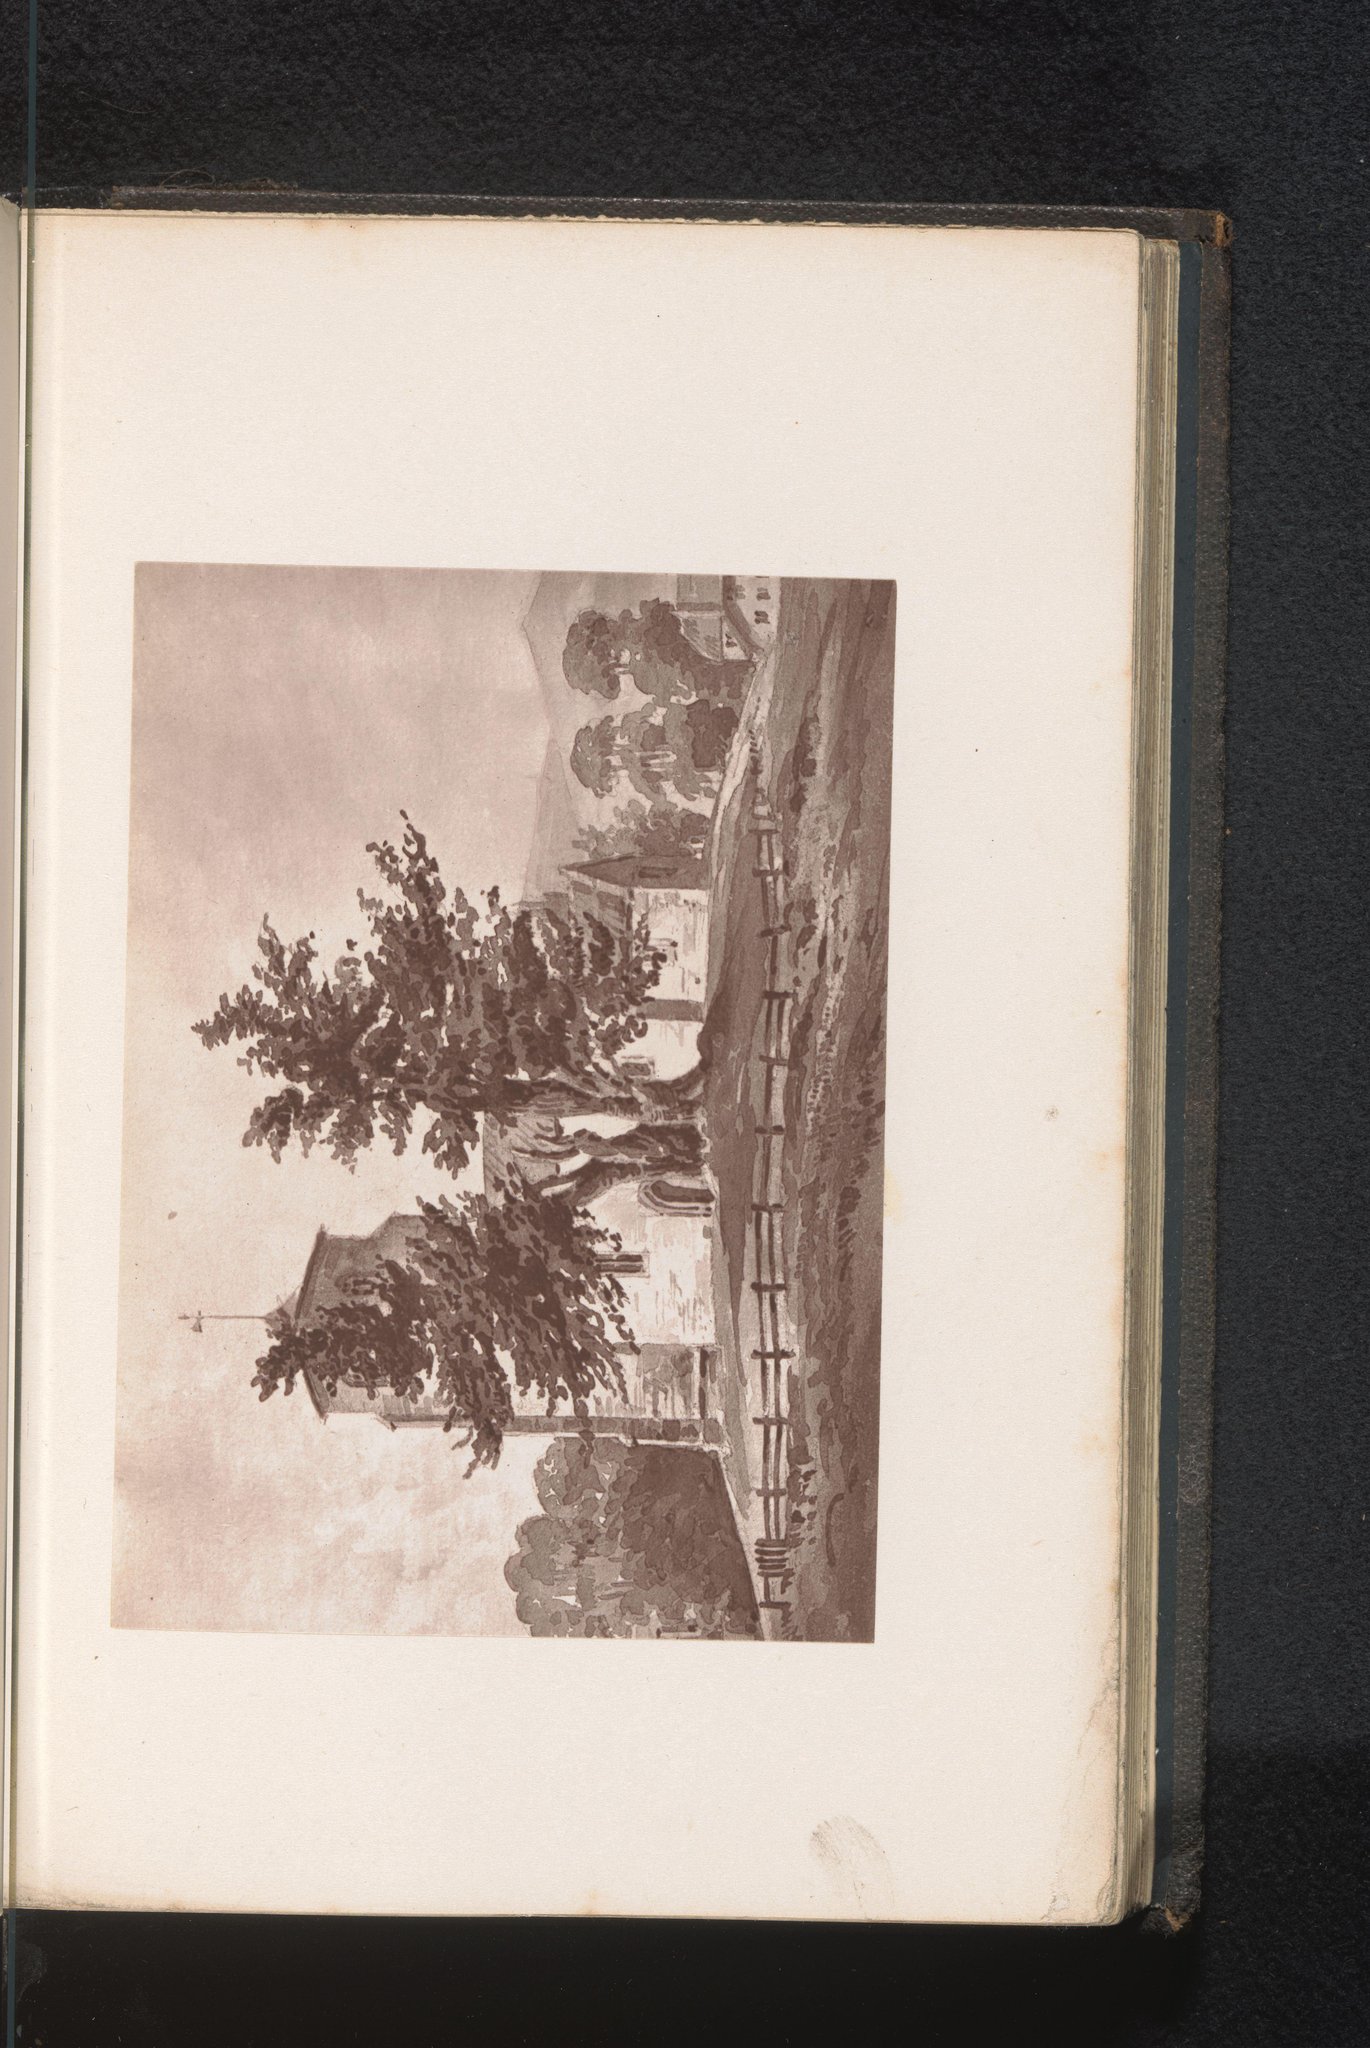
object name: reproduction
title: Fotoreproductie van een schildering, voorstellende een gezicht op All Saints Church te Alton Priors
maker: Anonymous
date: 1866-1876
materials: paper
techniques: woodburytype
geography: alton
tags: church (exterior), façade (of house or building)